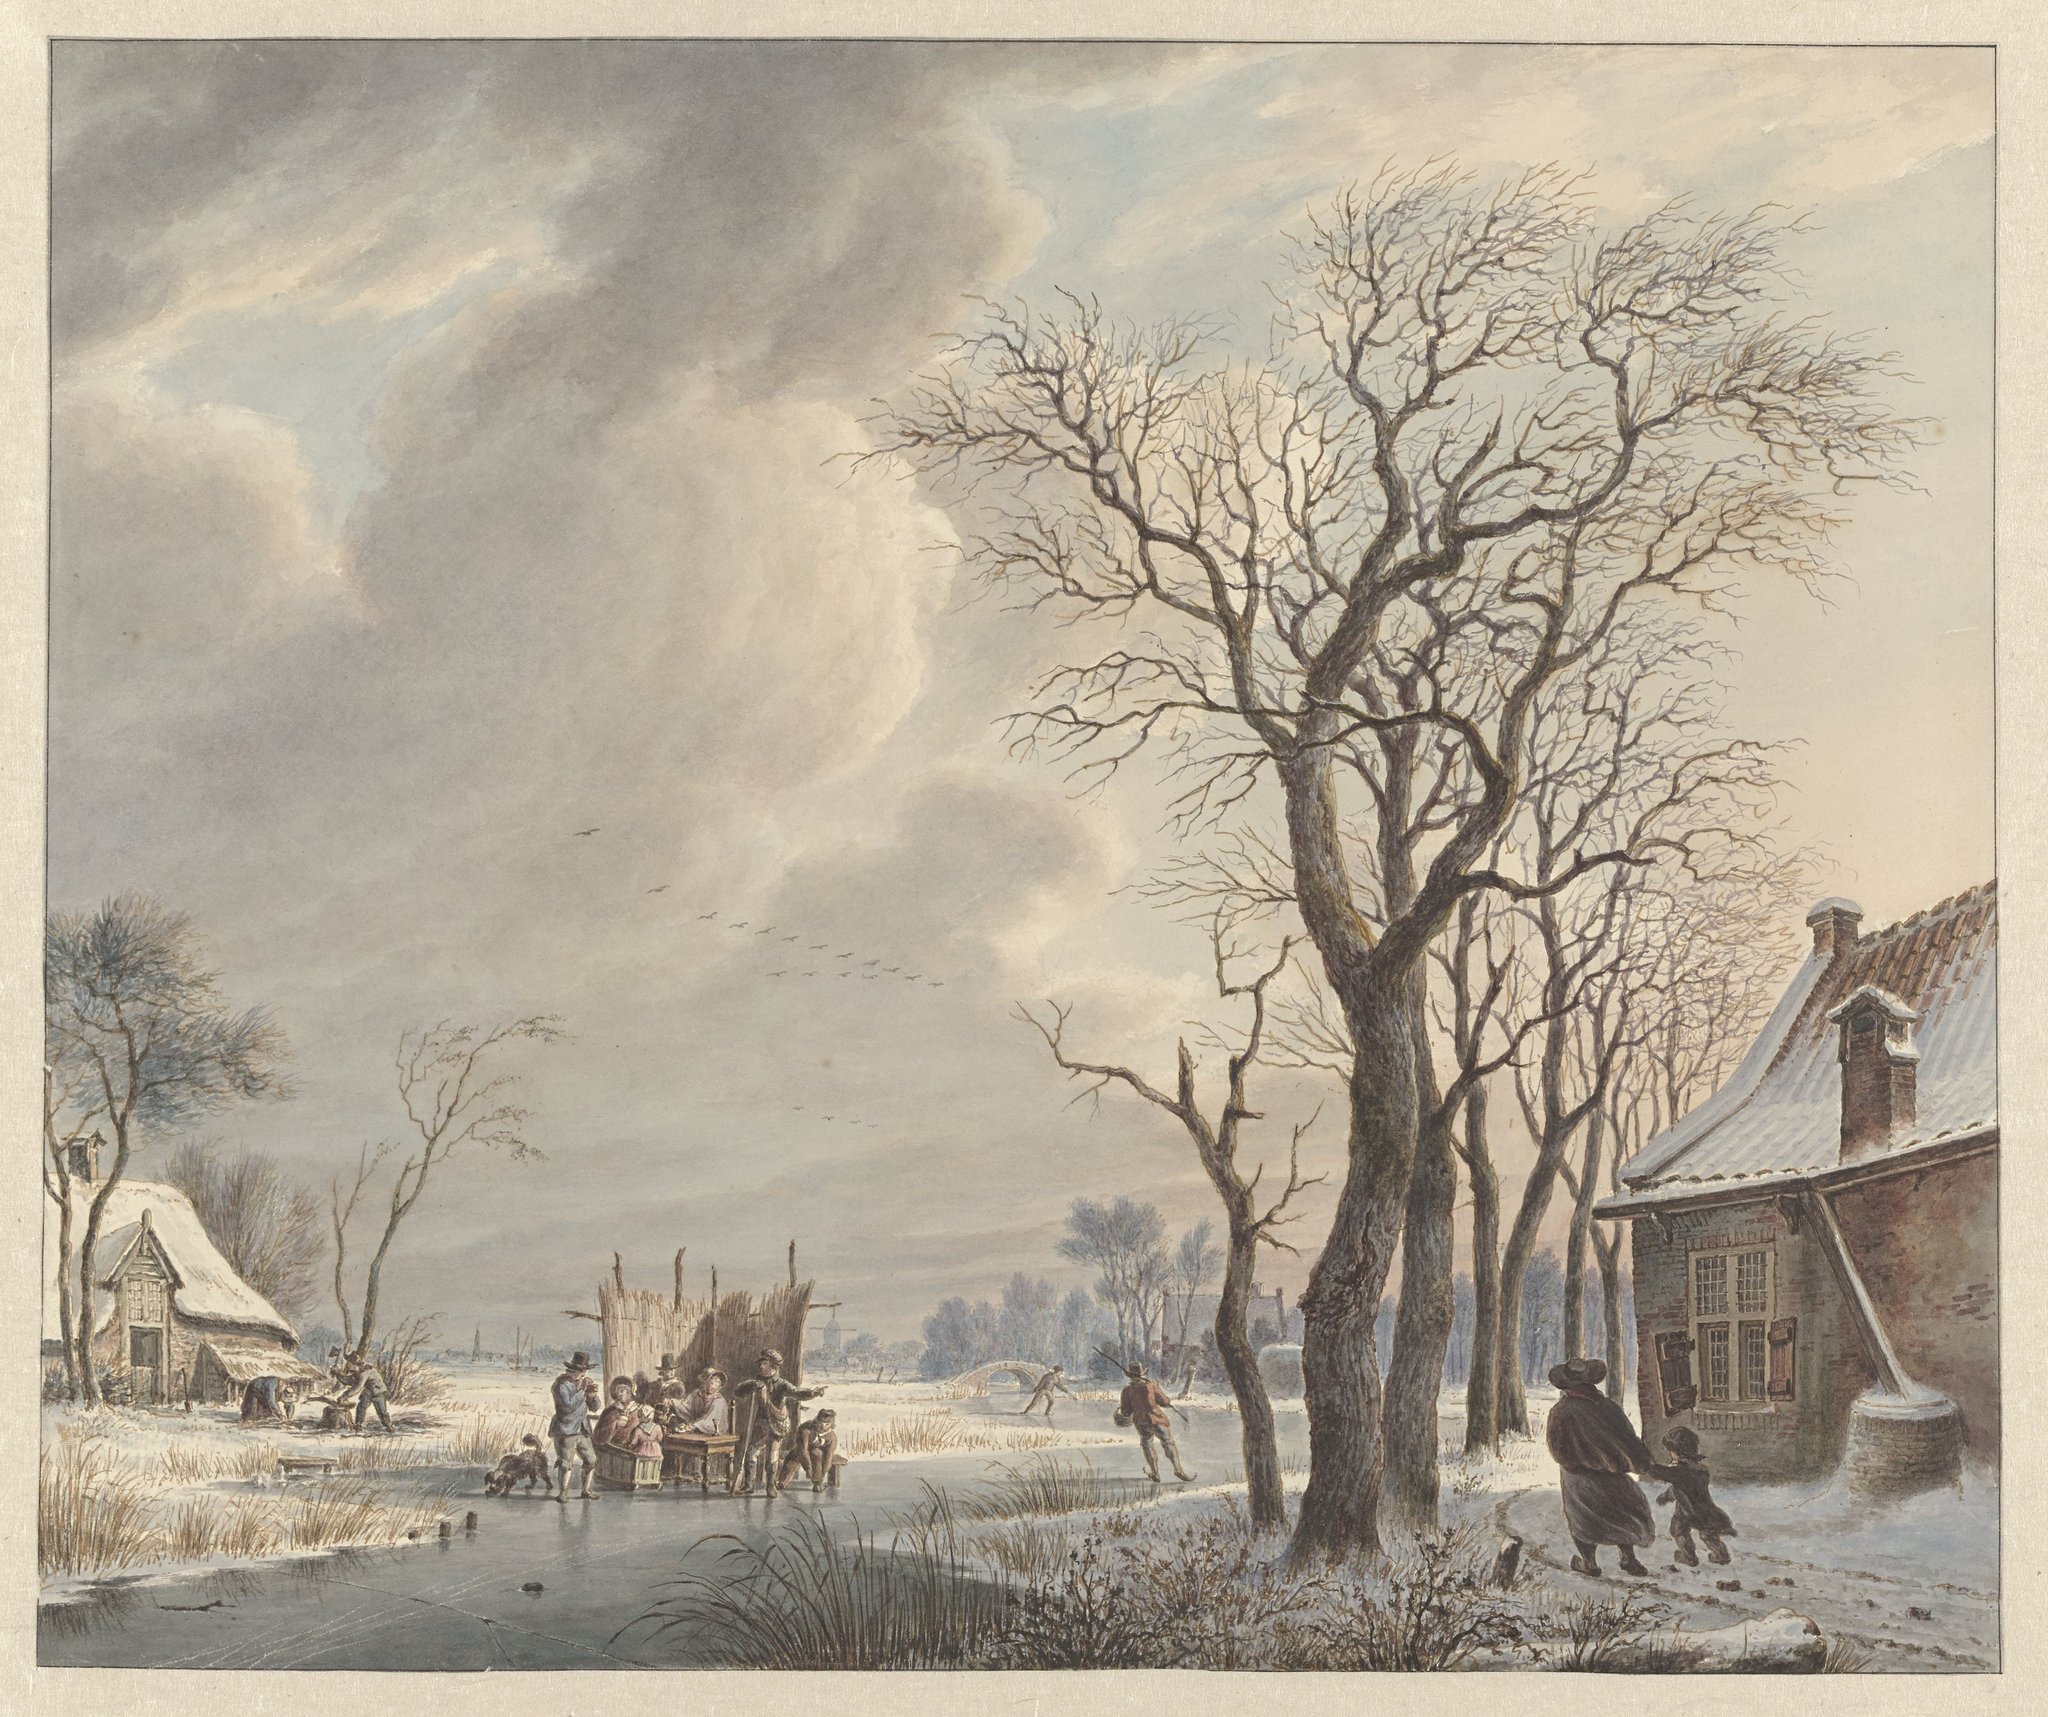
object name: drawing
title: Winterlandschap met ijsvermaak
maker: arend van glashorst jr.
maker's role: draughtsman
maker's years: 1796-1856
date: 1832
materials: ink, paper, watercolor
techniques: brush, pen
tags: winter sports, ice ~ freezing weather